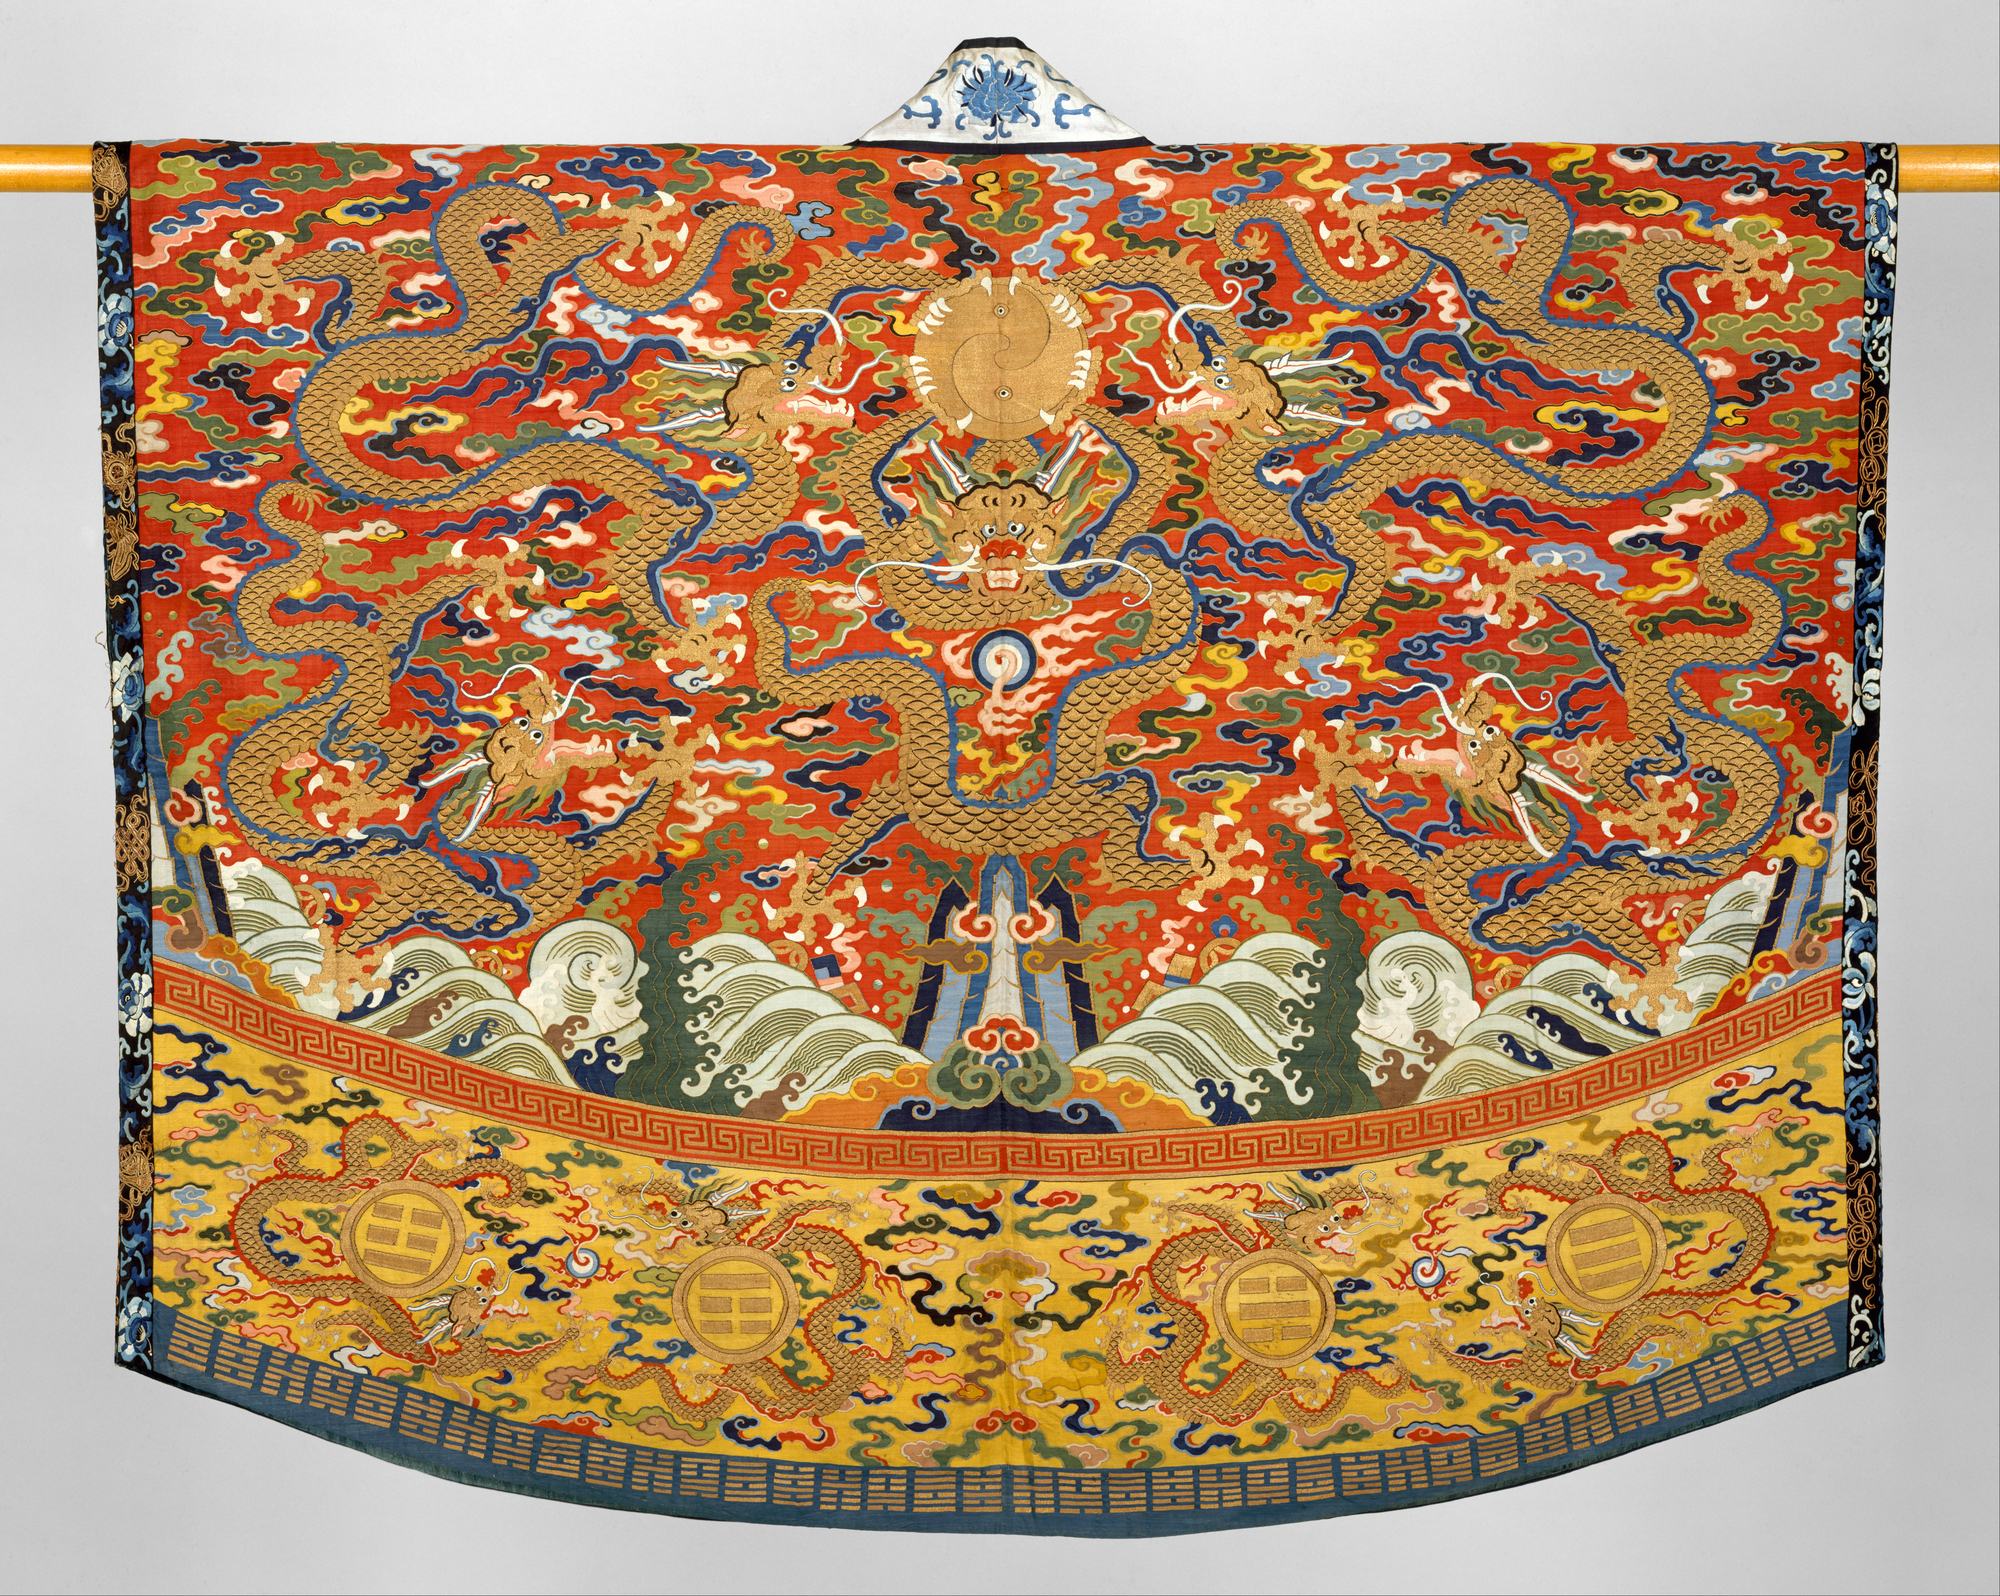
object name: daoist robe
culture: chinese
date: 1601-1700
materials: metal thread, silk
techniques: weave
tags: dragons